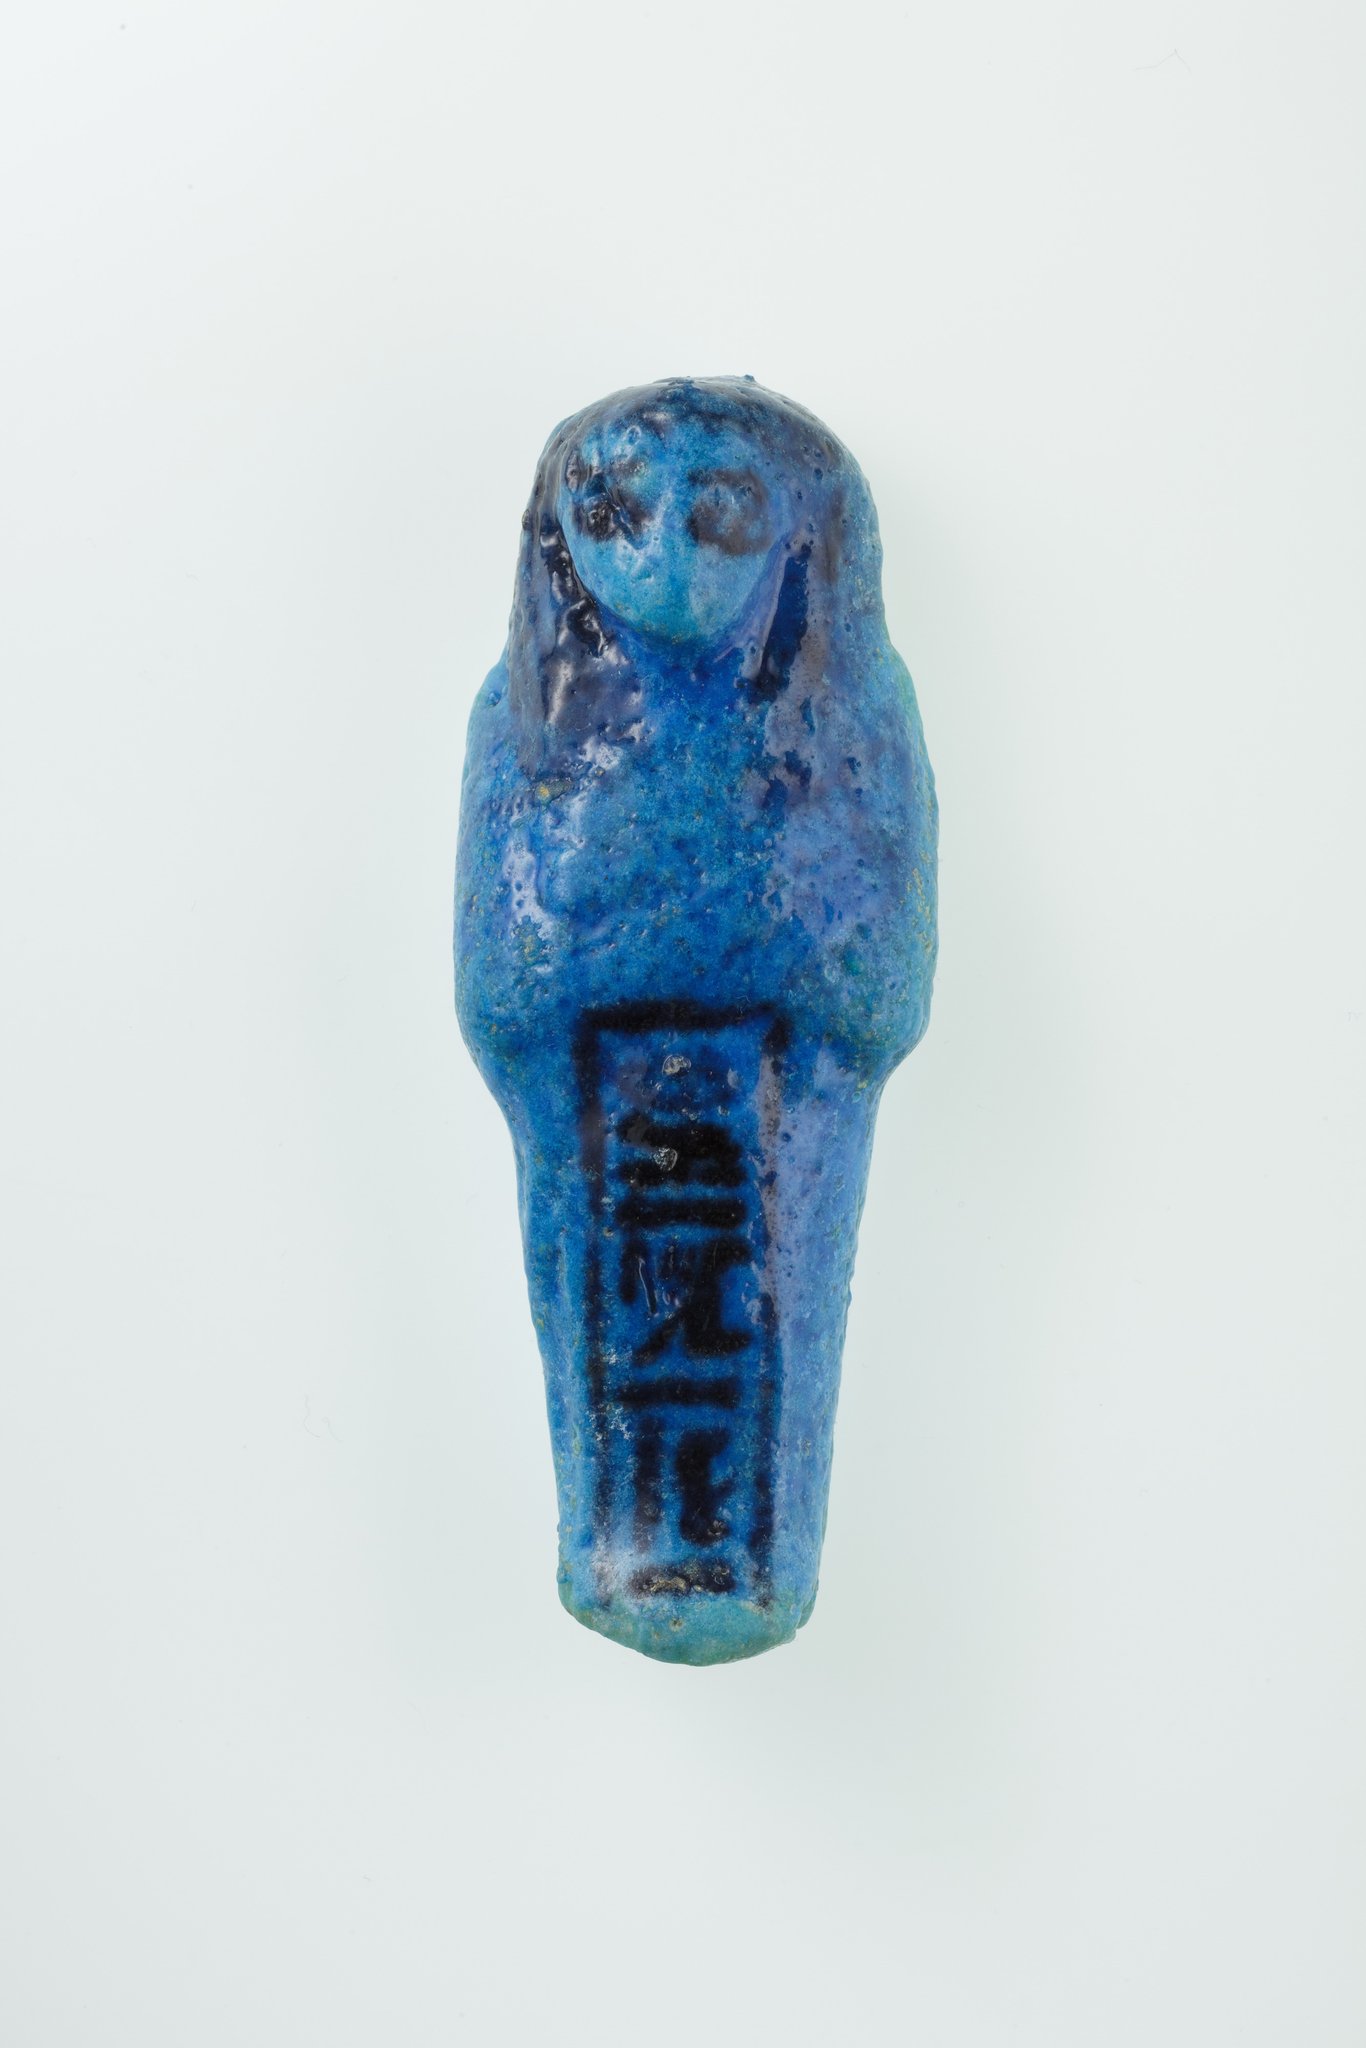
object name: shabti, worker, nauny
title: Worker Shabti of Nauny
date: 1050 BCE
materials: faience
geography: egypt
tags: hieroglyphs